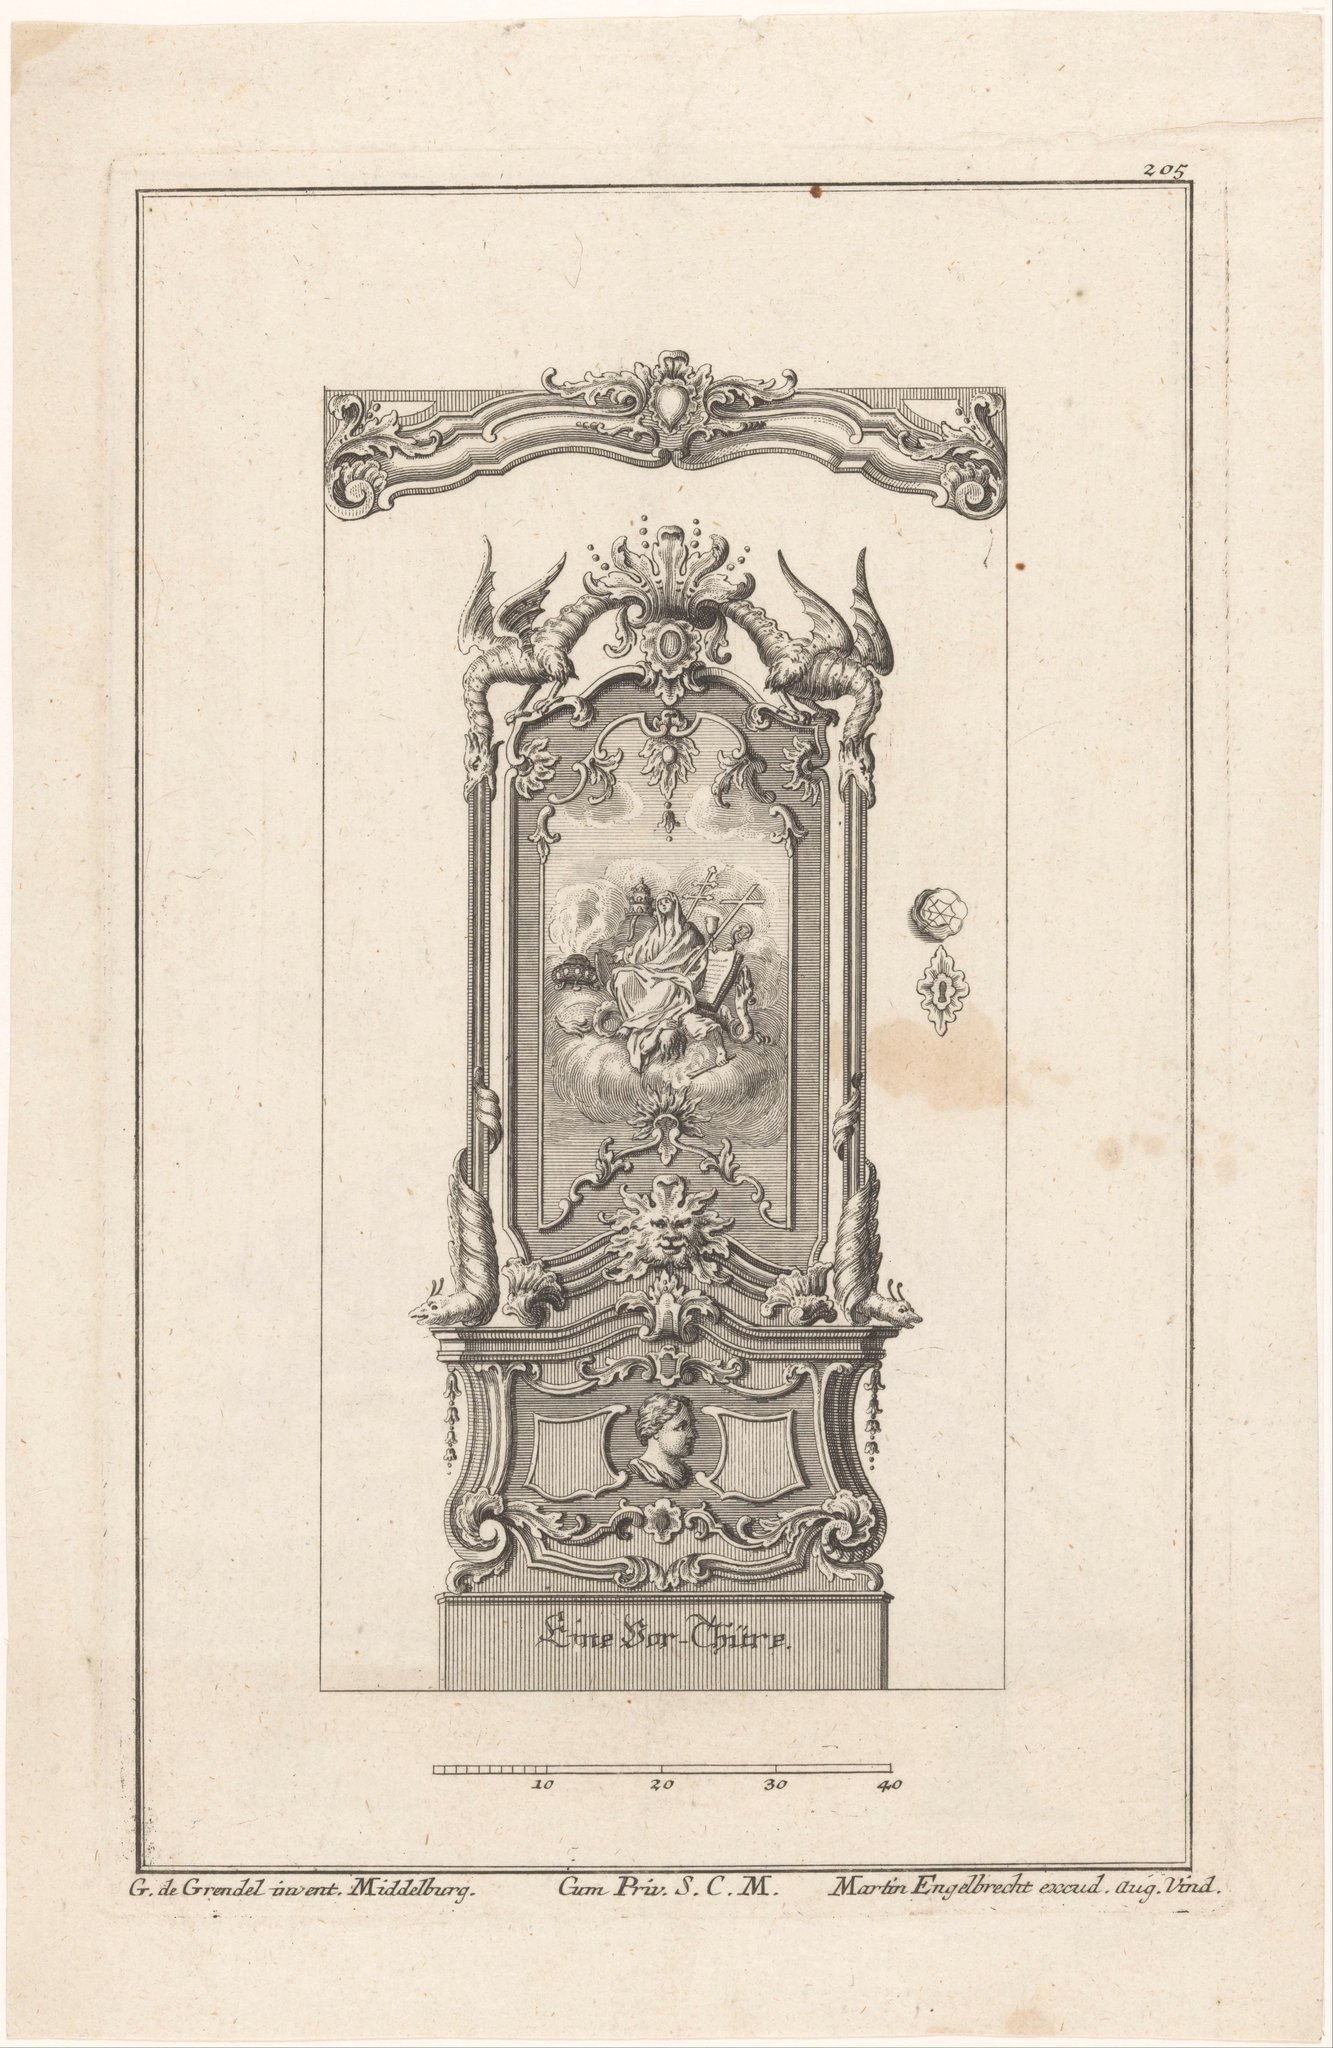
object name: print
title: Eine Vor-Thüre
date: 1708-1756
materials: paper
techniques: engraving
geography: augsburg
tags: ornament derived from animal forms, faith, 'fides'; 'fede', 'fede catholica', 'fede christiana', 'fede christiana catholica' (ripa) ~ one of the three theological virtues, mask, mascaron ~ ornament, dragon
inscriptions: collector's mark: Lugt 2228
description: Ontwerp voor een voordeur met een voorstelling van Geloof, zittende op een wolk, met rondom haar een wierookvat, de pauselijke tiara, kruisen, een Bijbel en een miskelk. Onder haar voeten de verslagen Dood. De deur is versierd met bladornamenten, draken, masker en slakachtige figuren. Midden onder een schaalverdeling. Prentnummer 205.